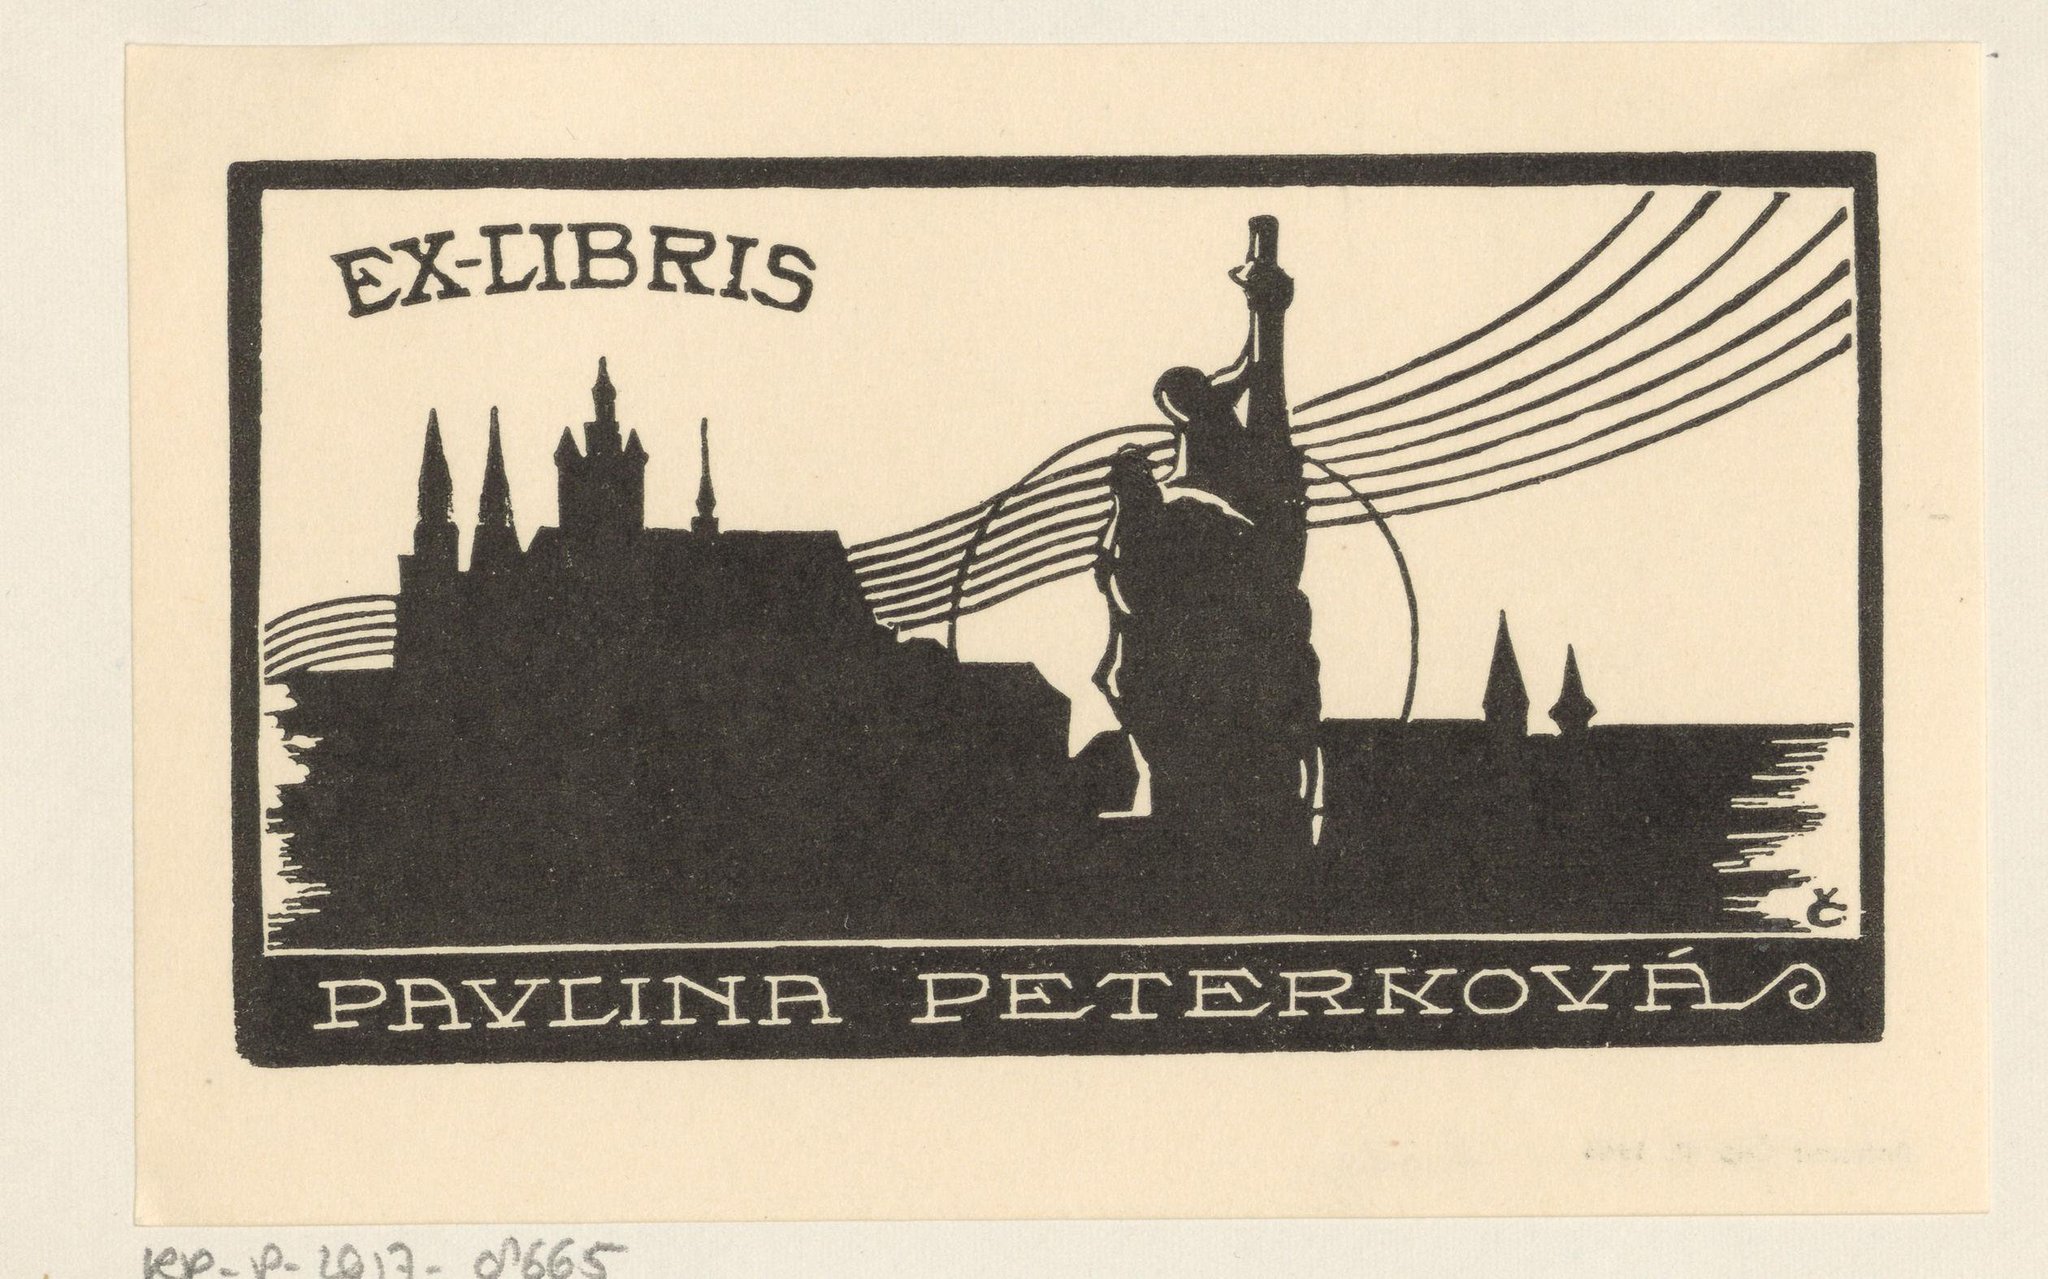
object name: bookplate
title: Ex-libris Paulina Peterková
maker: bohumír čáp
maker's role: print maker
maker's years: 1870-1947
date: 1943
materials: paper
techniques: woodcut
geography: czech republic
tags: church (exterior)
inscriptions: inscription: ‘Bohumír Čáp dř, 1943’